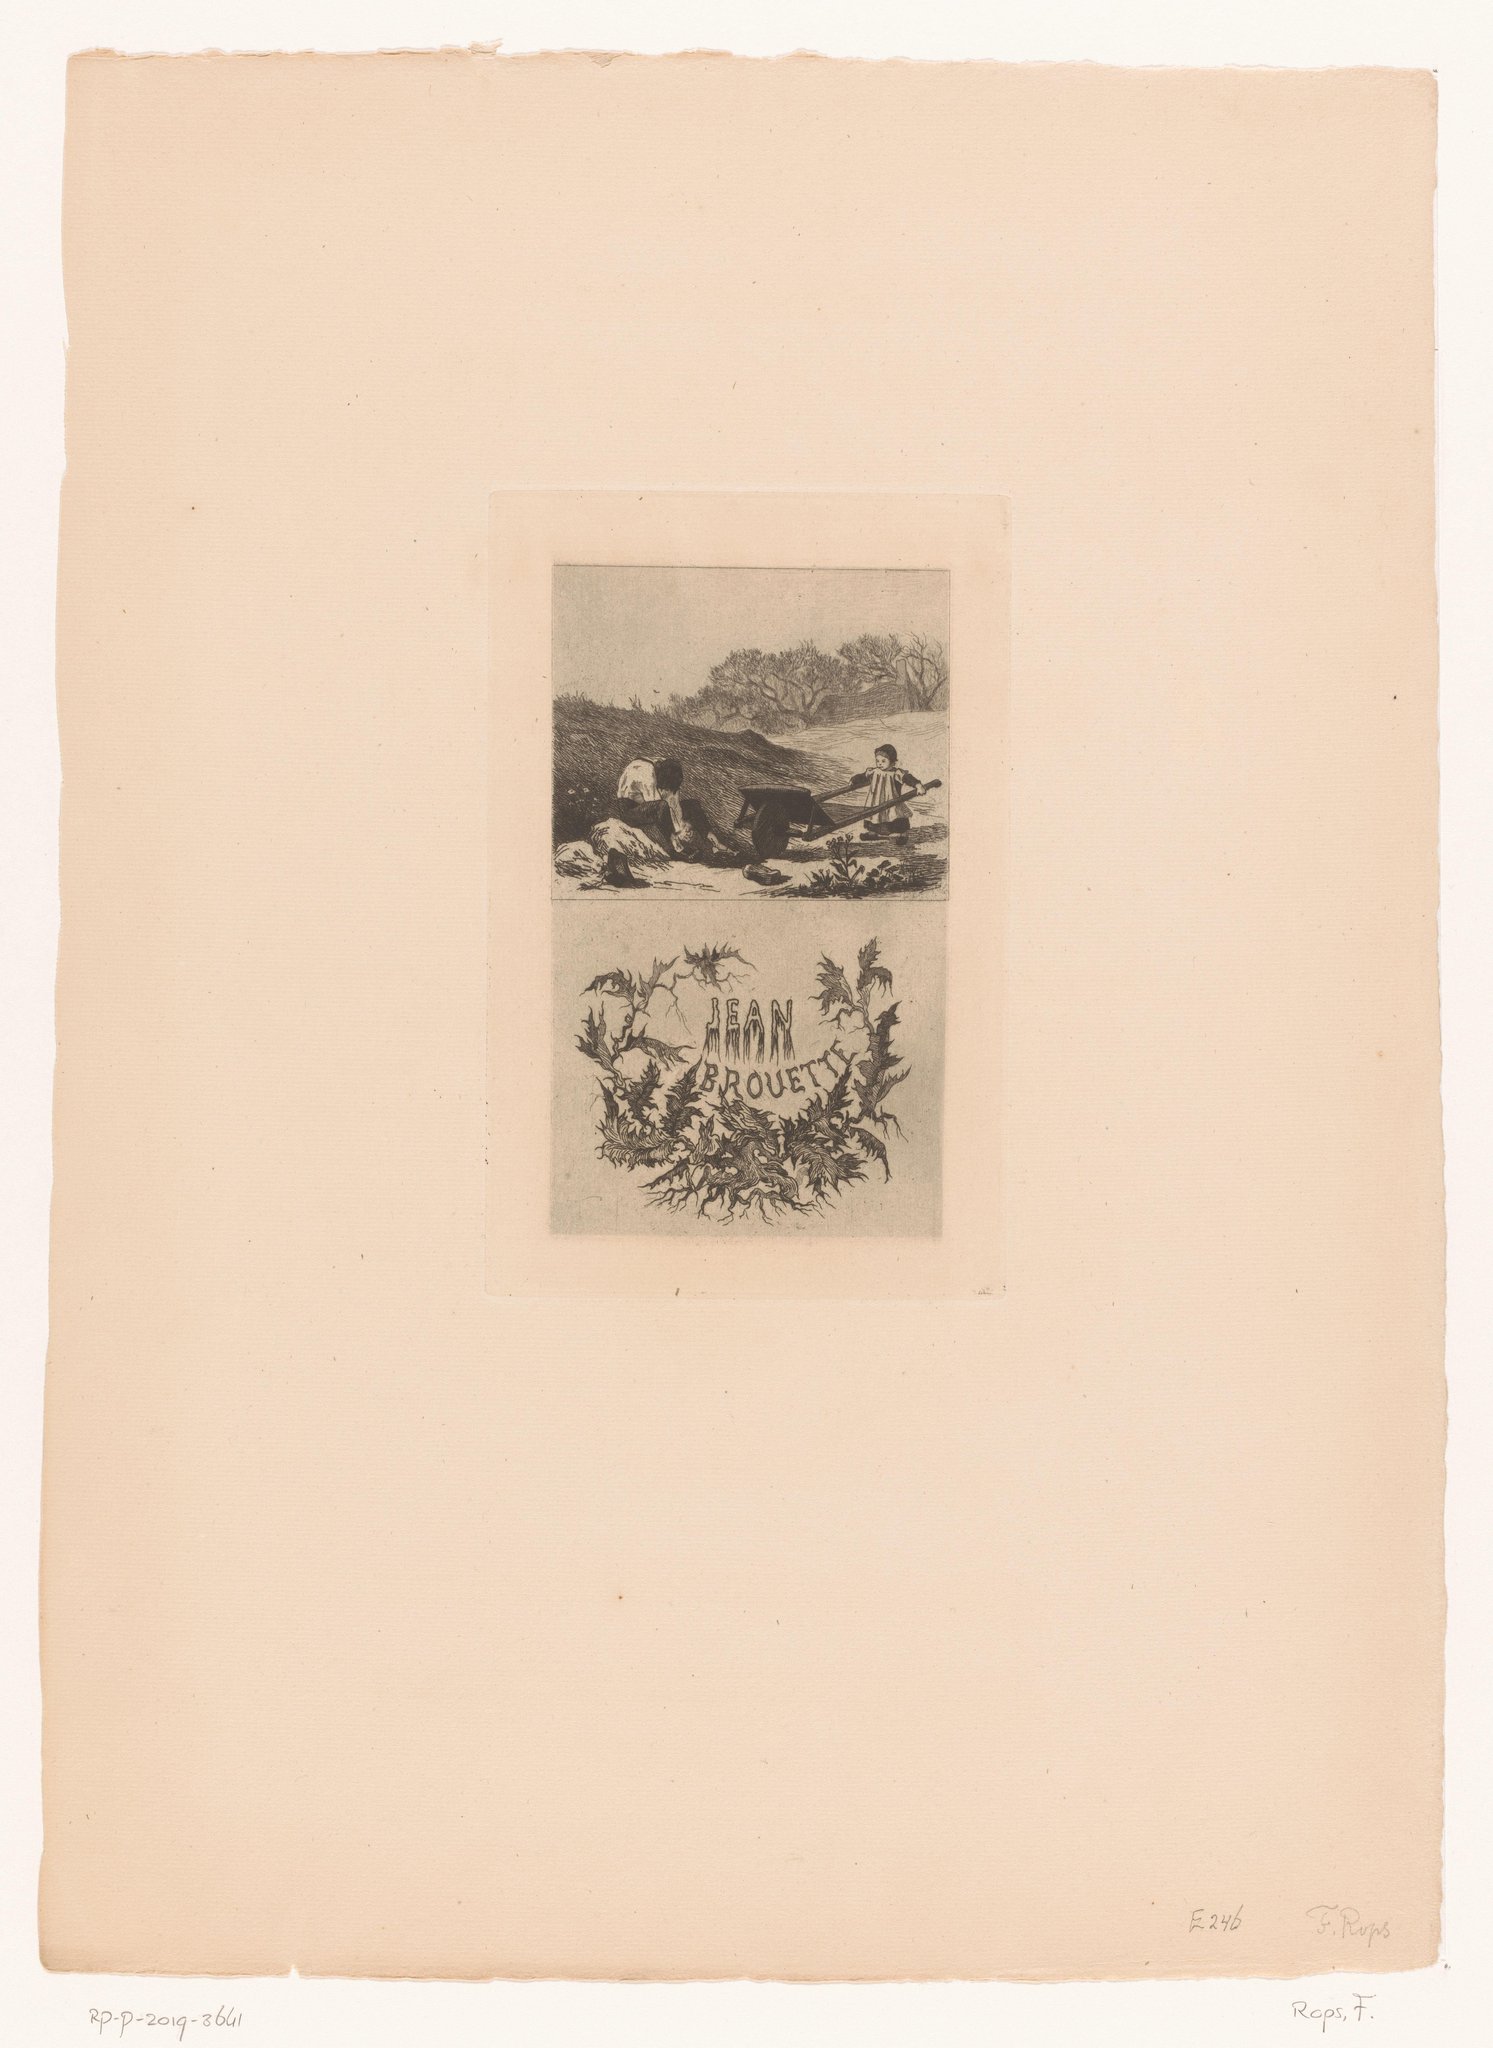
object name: print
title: Man en kind met kruiwagen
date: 1875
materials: paper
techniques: aquatint, etching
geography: brussels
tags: adult man, wheelbarrow, tot, toddler ~ the ages of man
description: Prent uit: Rops, Félicien (red.), Cahier d'études eaux-fortes originales et inédites. Brussel: Felix Callewaert père, 1875.